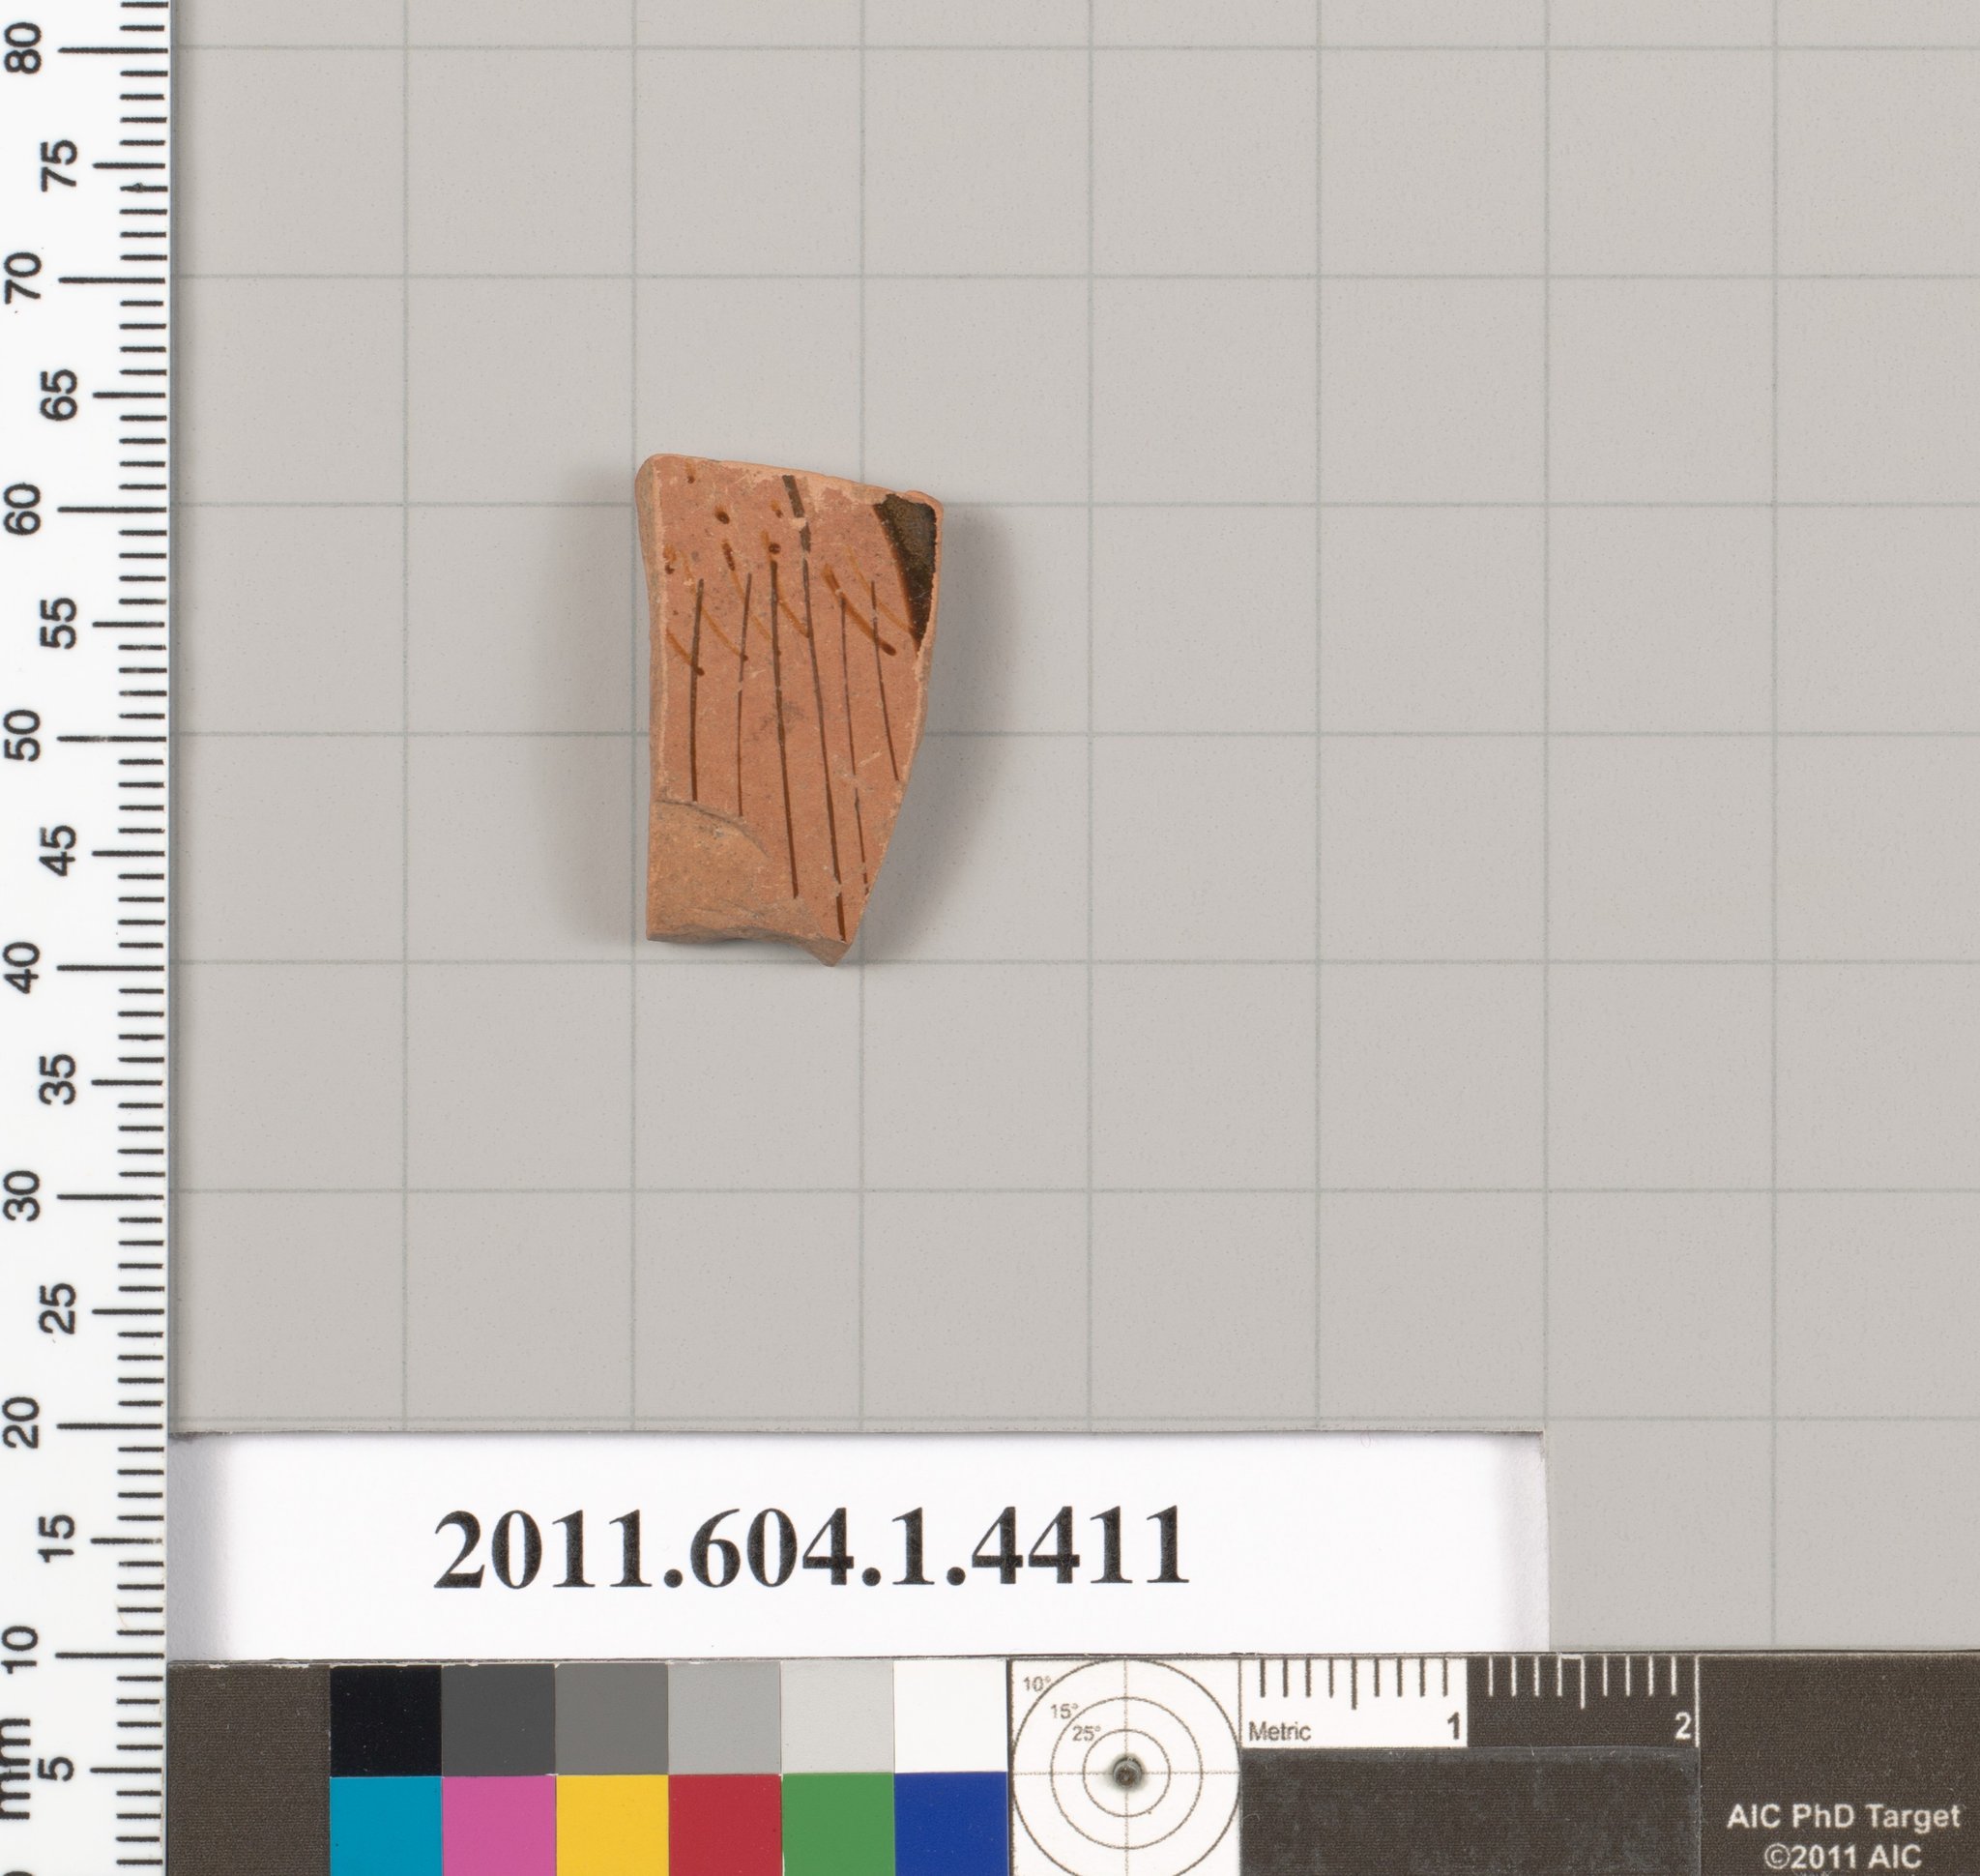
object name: kylix fragment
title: Terracotta fragment of a kylix (drinking cup)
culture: greek, attic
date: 475-451 BCE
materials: terracotta